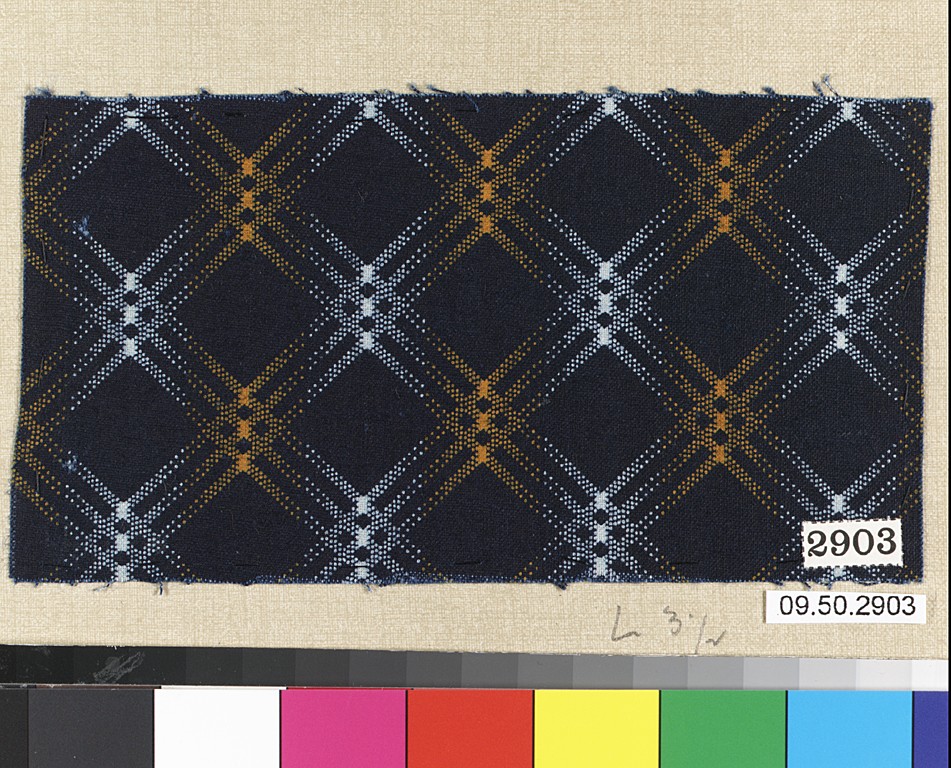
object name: piece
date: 1801-1900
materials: cotton